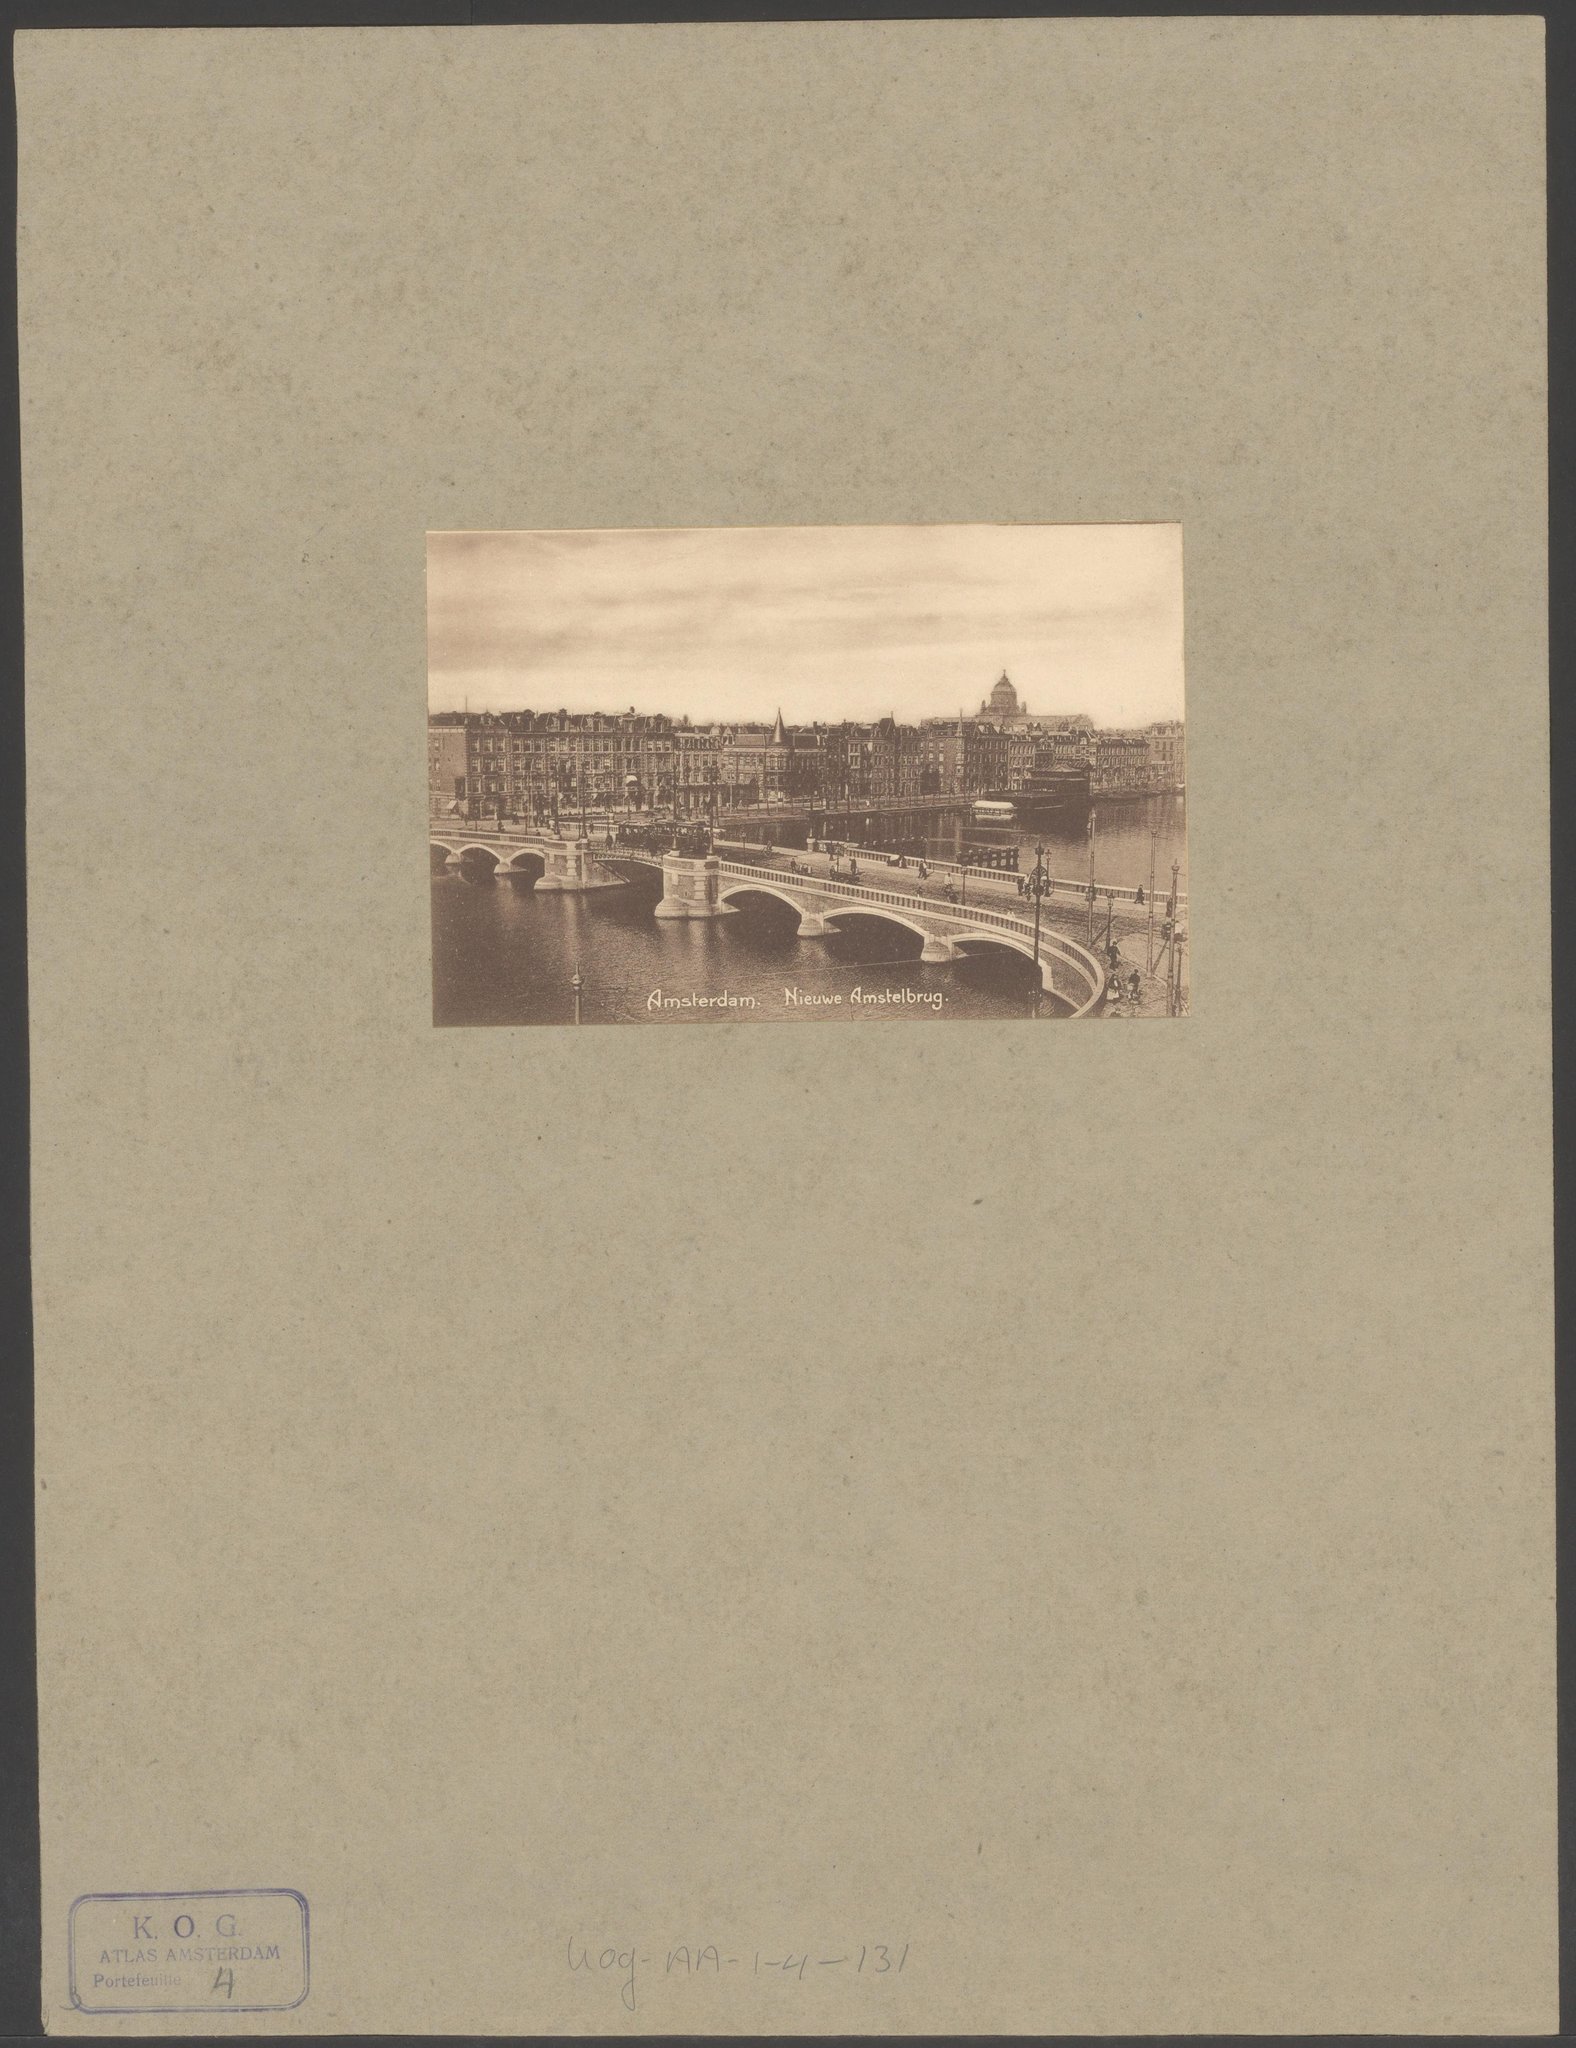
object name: photomechanical print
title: Gezicht op de Amstel en de Nieuwe Amstelbrug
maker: Anonymous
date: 1903-1950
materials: cardboard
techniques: photograph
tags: city-view in general; 'veduta', river, bridge in city across river, canal, etc.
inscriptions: collector's mark: ‘4’ Lugt 1641b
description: Onderwerpsrubriek binnen de Atlas Amsterdam: Amstel van Hogesluis stroomopwaarts.